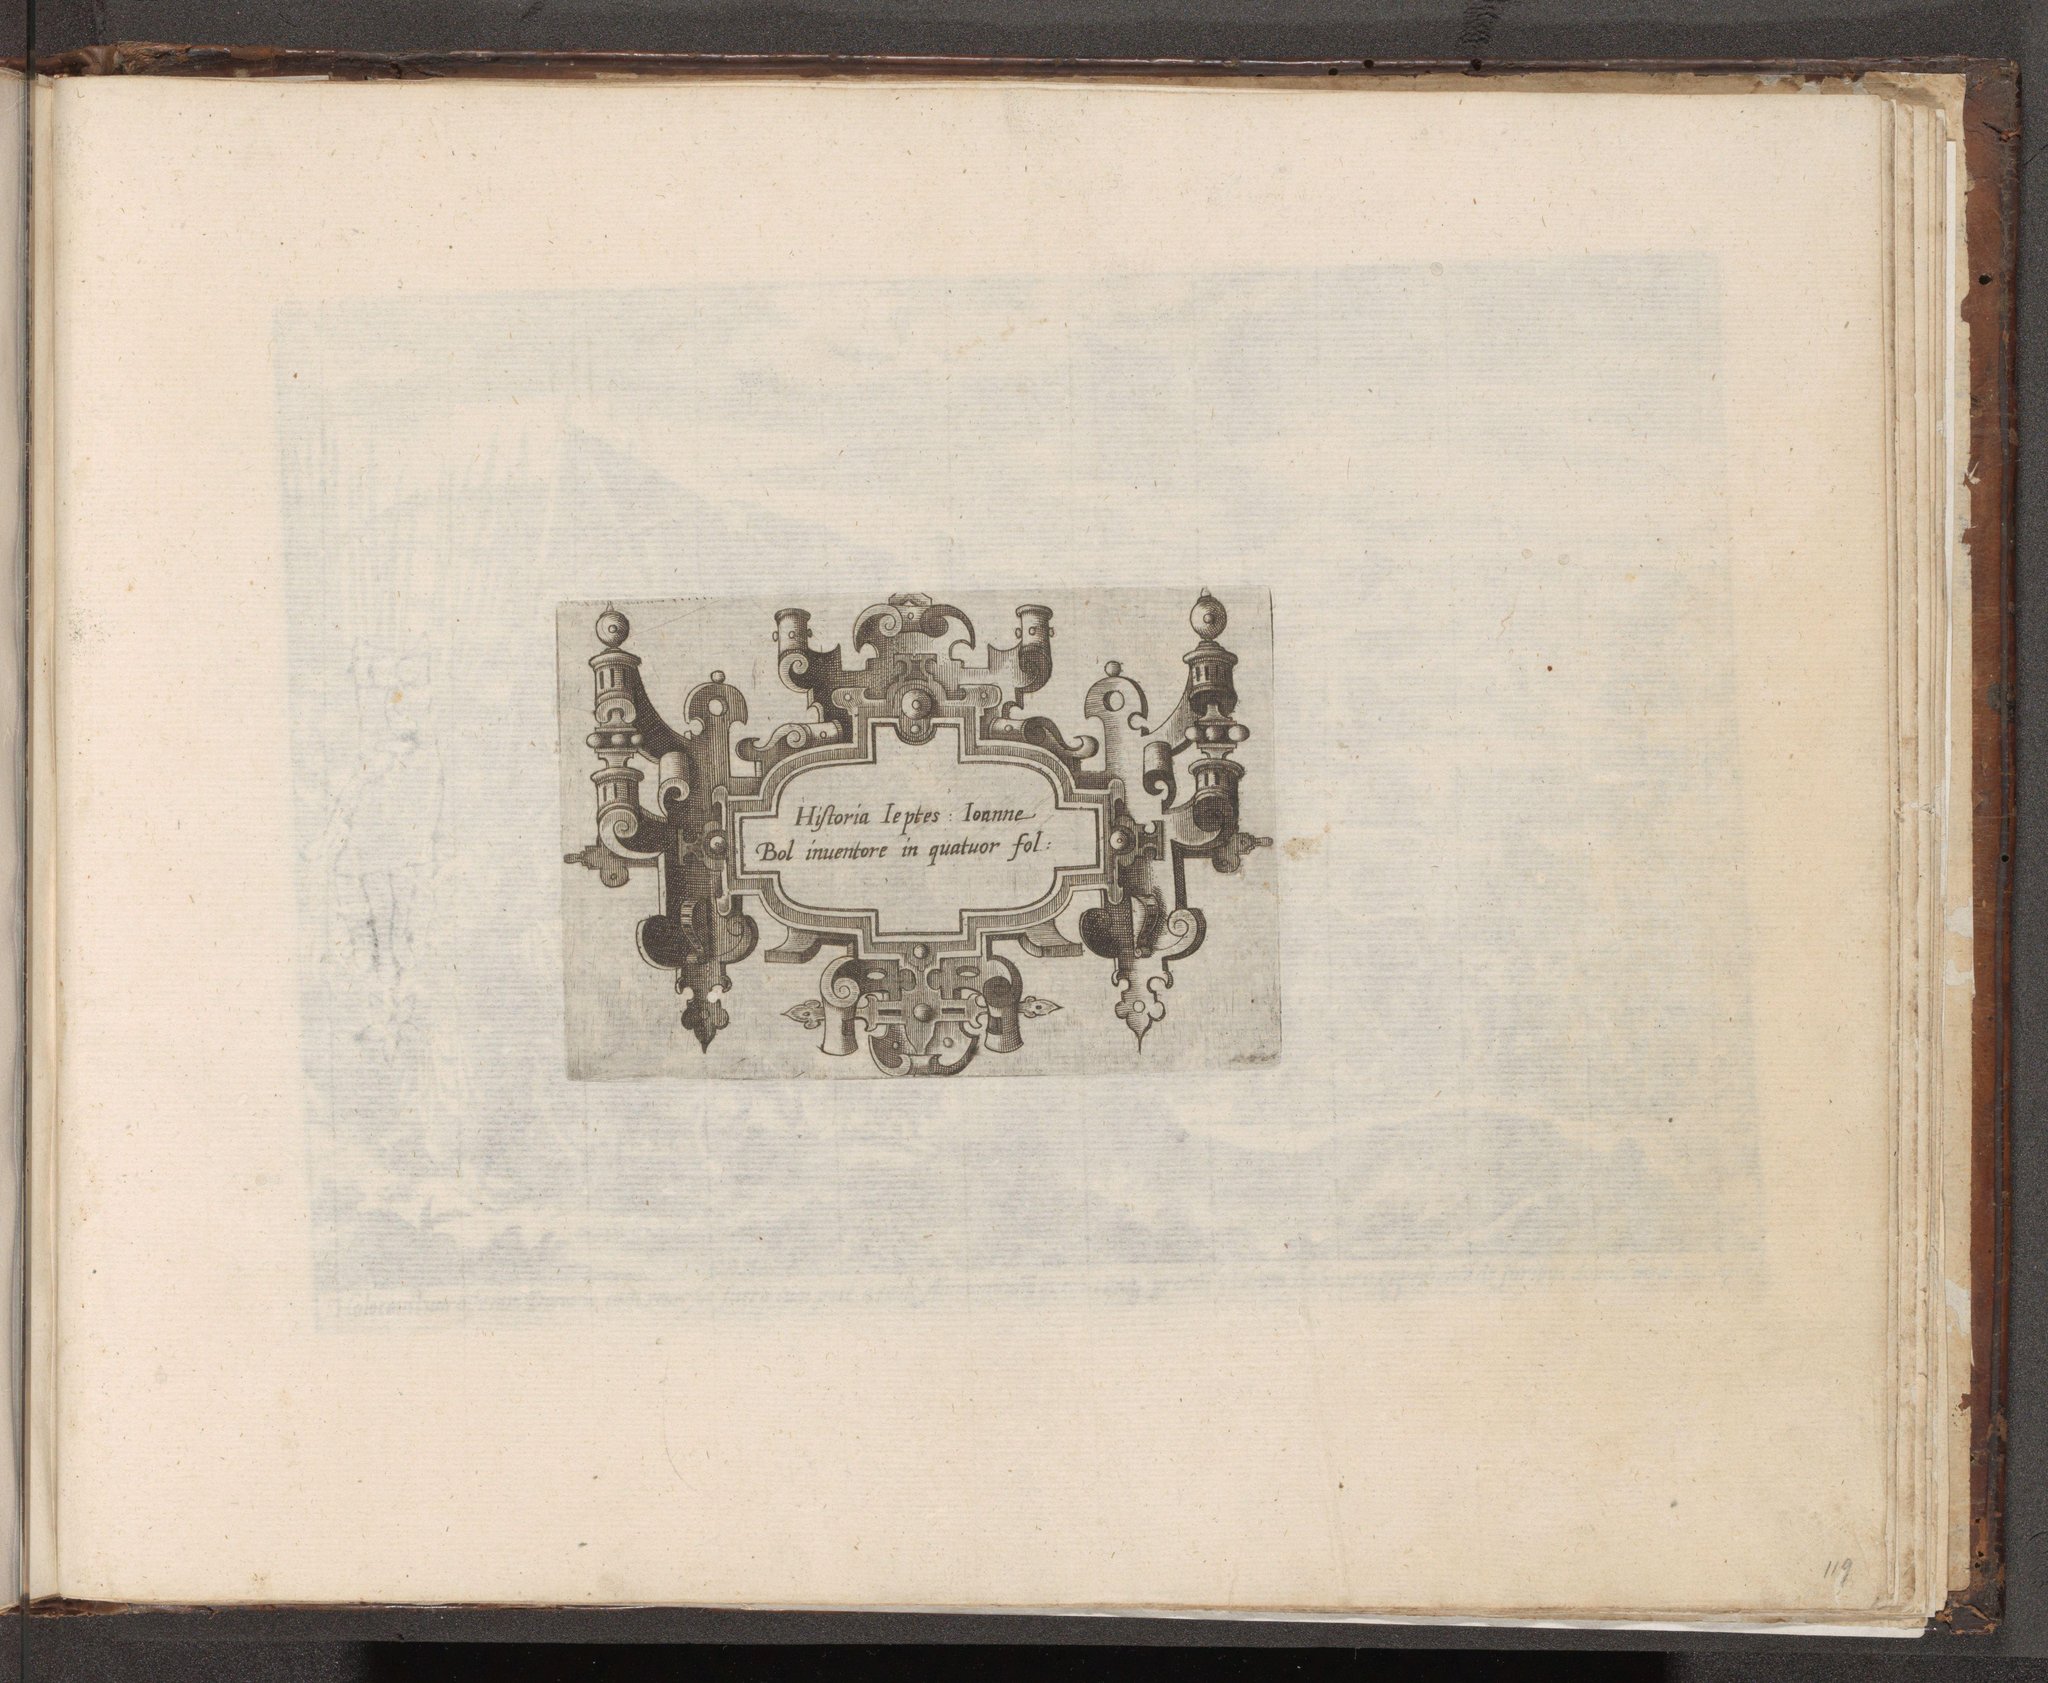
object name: album leaf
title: Historia Jeptes : Joanne Bol inventore in quatuor fol :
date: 1579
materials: paper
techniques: engraving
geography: antwerp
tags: scrollwork, strapwork ~ ornament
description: Titel in cartouche met rolwerk. Titelprent voor een serie prenten over de geschiedenis van Jefta. Prent maakt deel uit van een album.